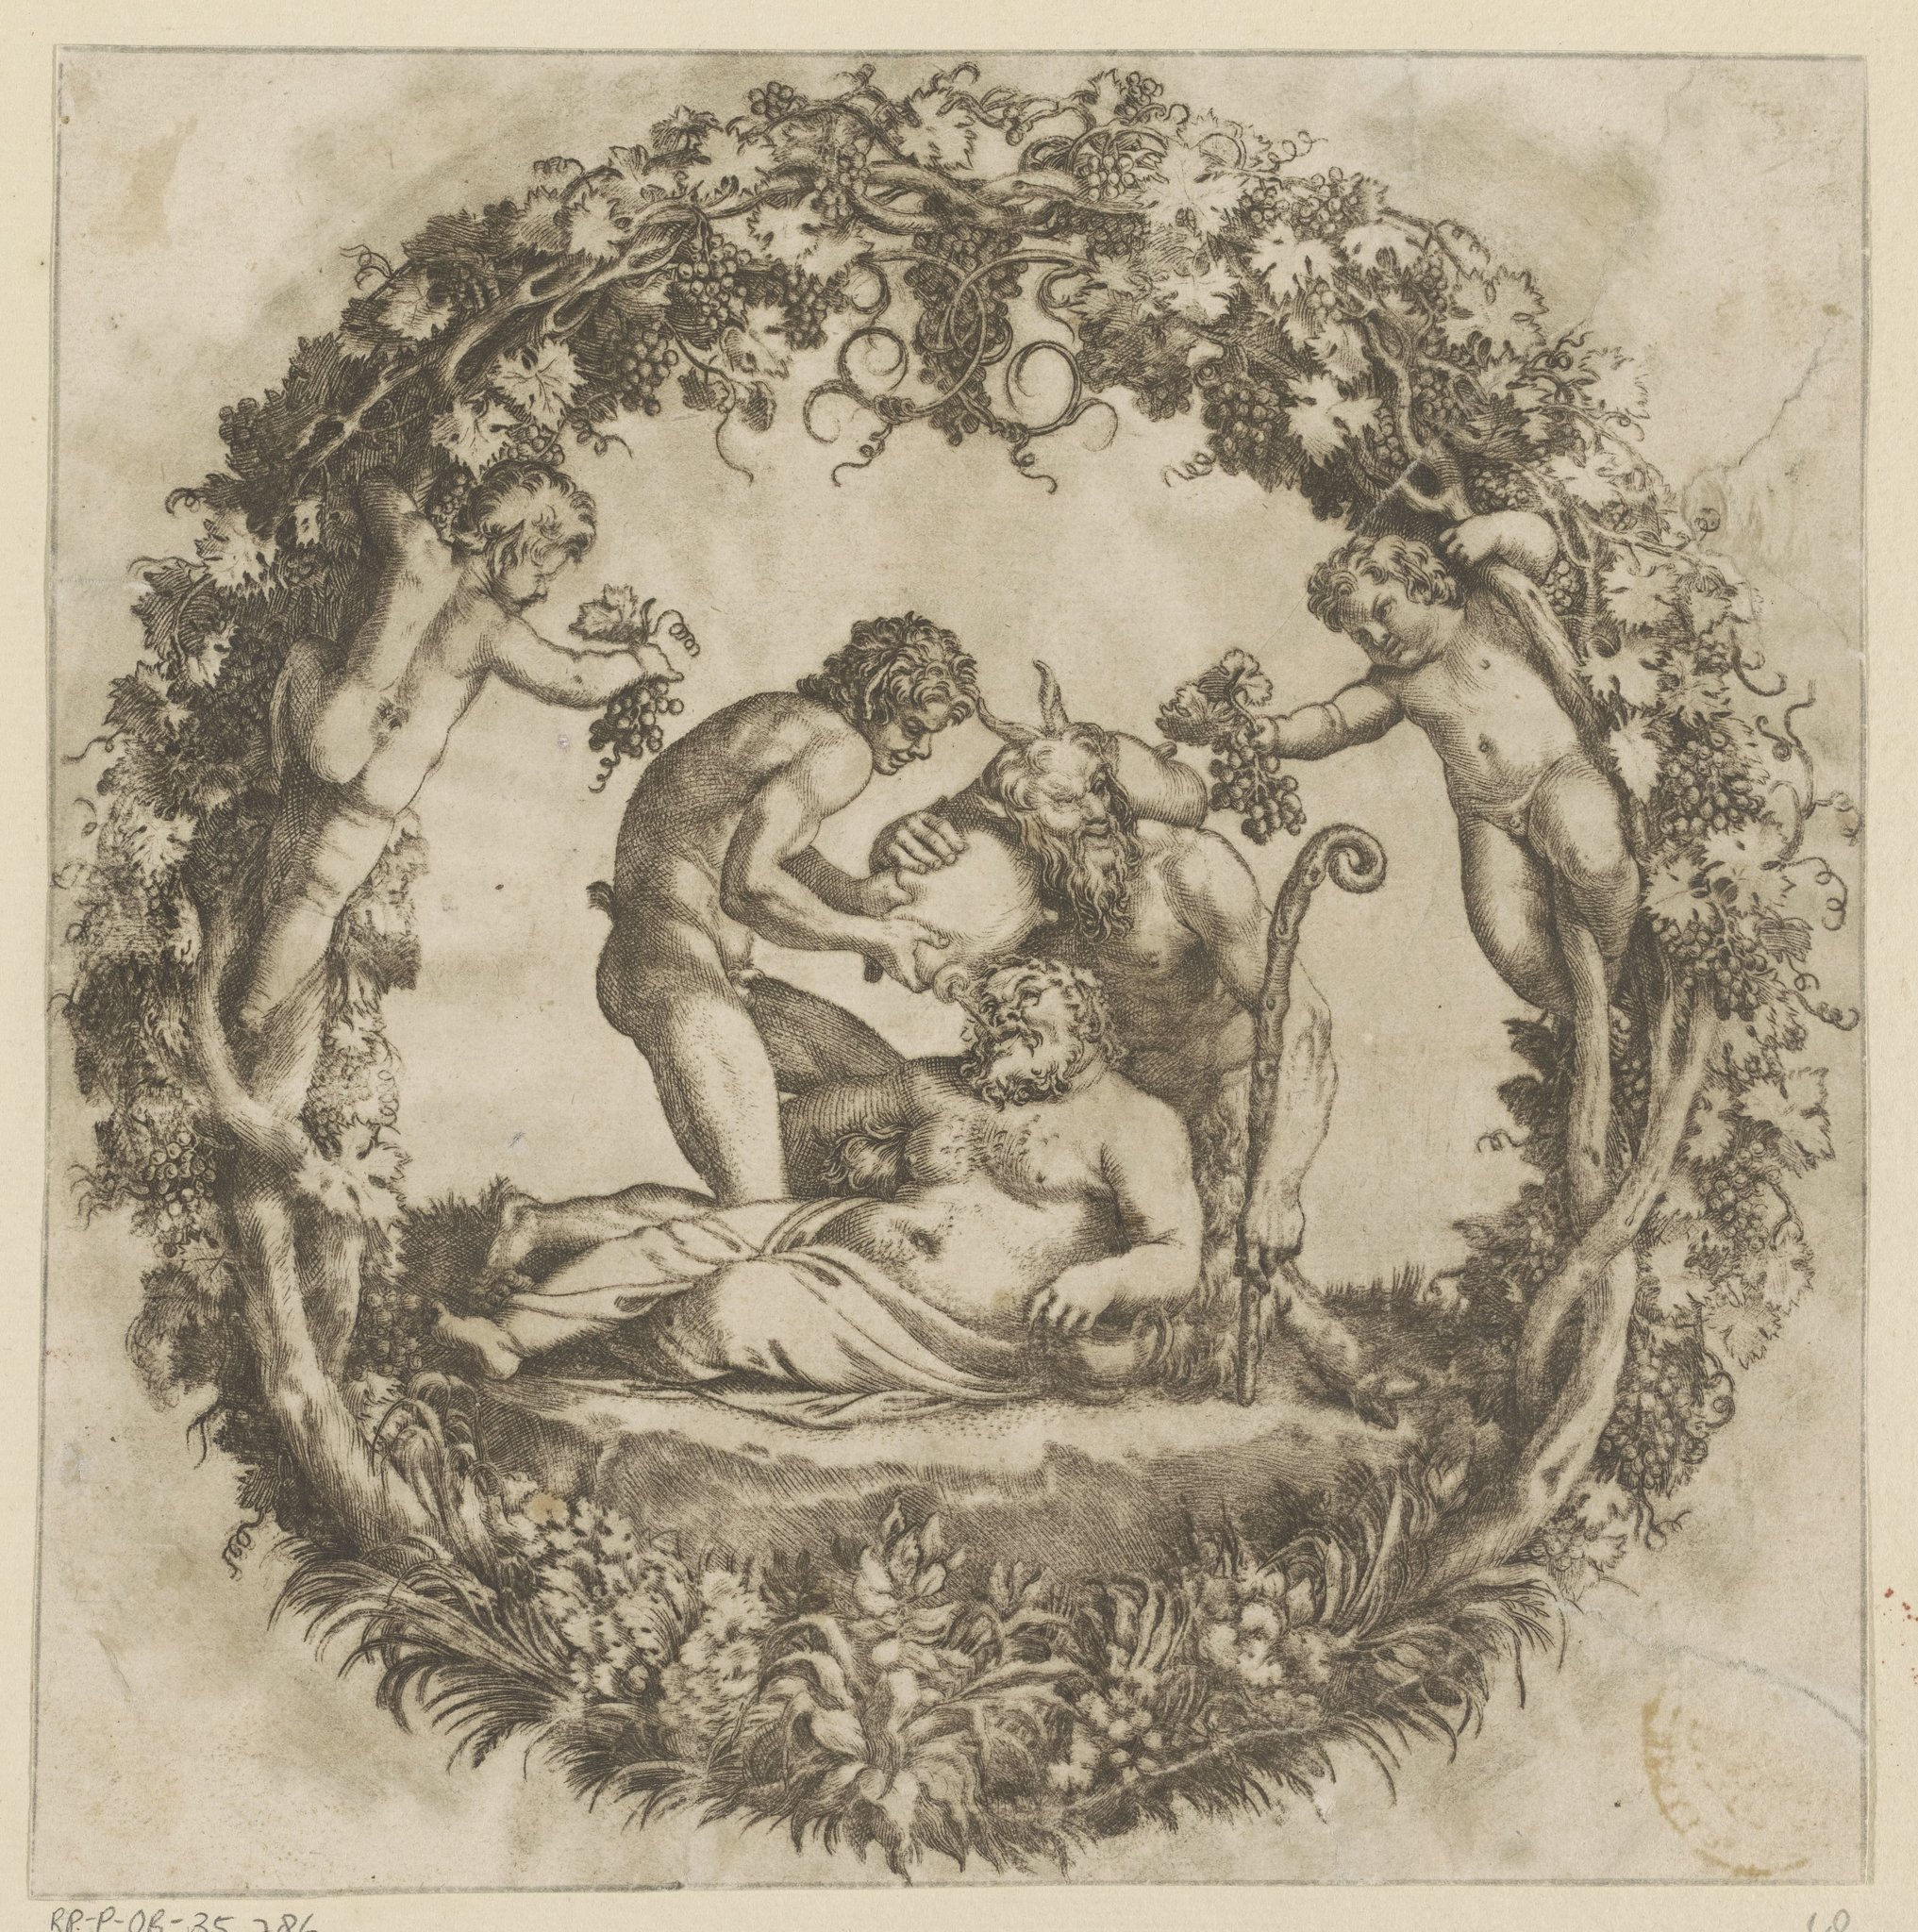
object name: print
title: De Tazza Farnese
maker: annibale carracci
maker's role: draughtsman, print maker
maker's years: 1560-1609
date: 1597-1600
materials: paper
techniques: engraving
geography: italy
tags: (story of) silenus, satyr(s) (in general), drunkenness, cupids: 'amores', 'amoretti', 'putti', grape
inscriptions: collector's mark: Lugt 240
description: Afdruk van een gegraveerd zilveren bord (de Tazza Farnese), vervaardigd door Annibale Carracci voor kardinaal Odoardo Farnese. Het bord wordt bewaard in het Museo Nazionale di Capodimonte te Napels.